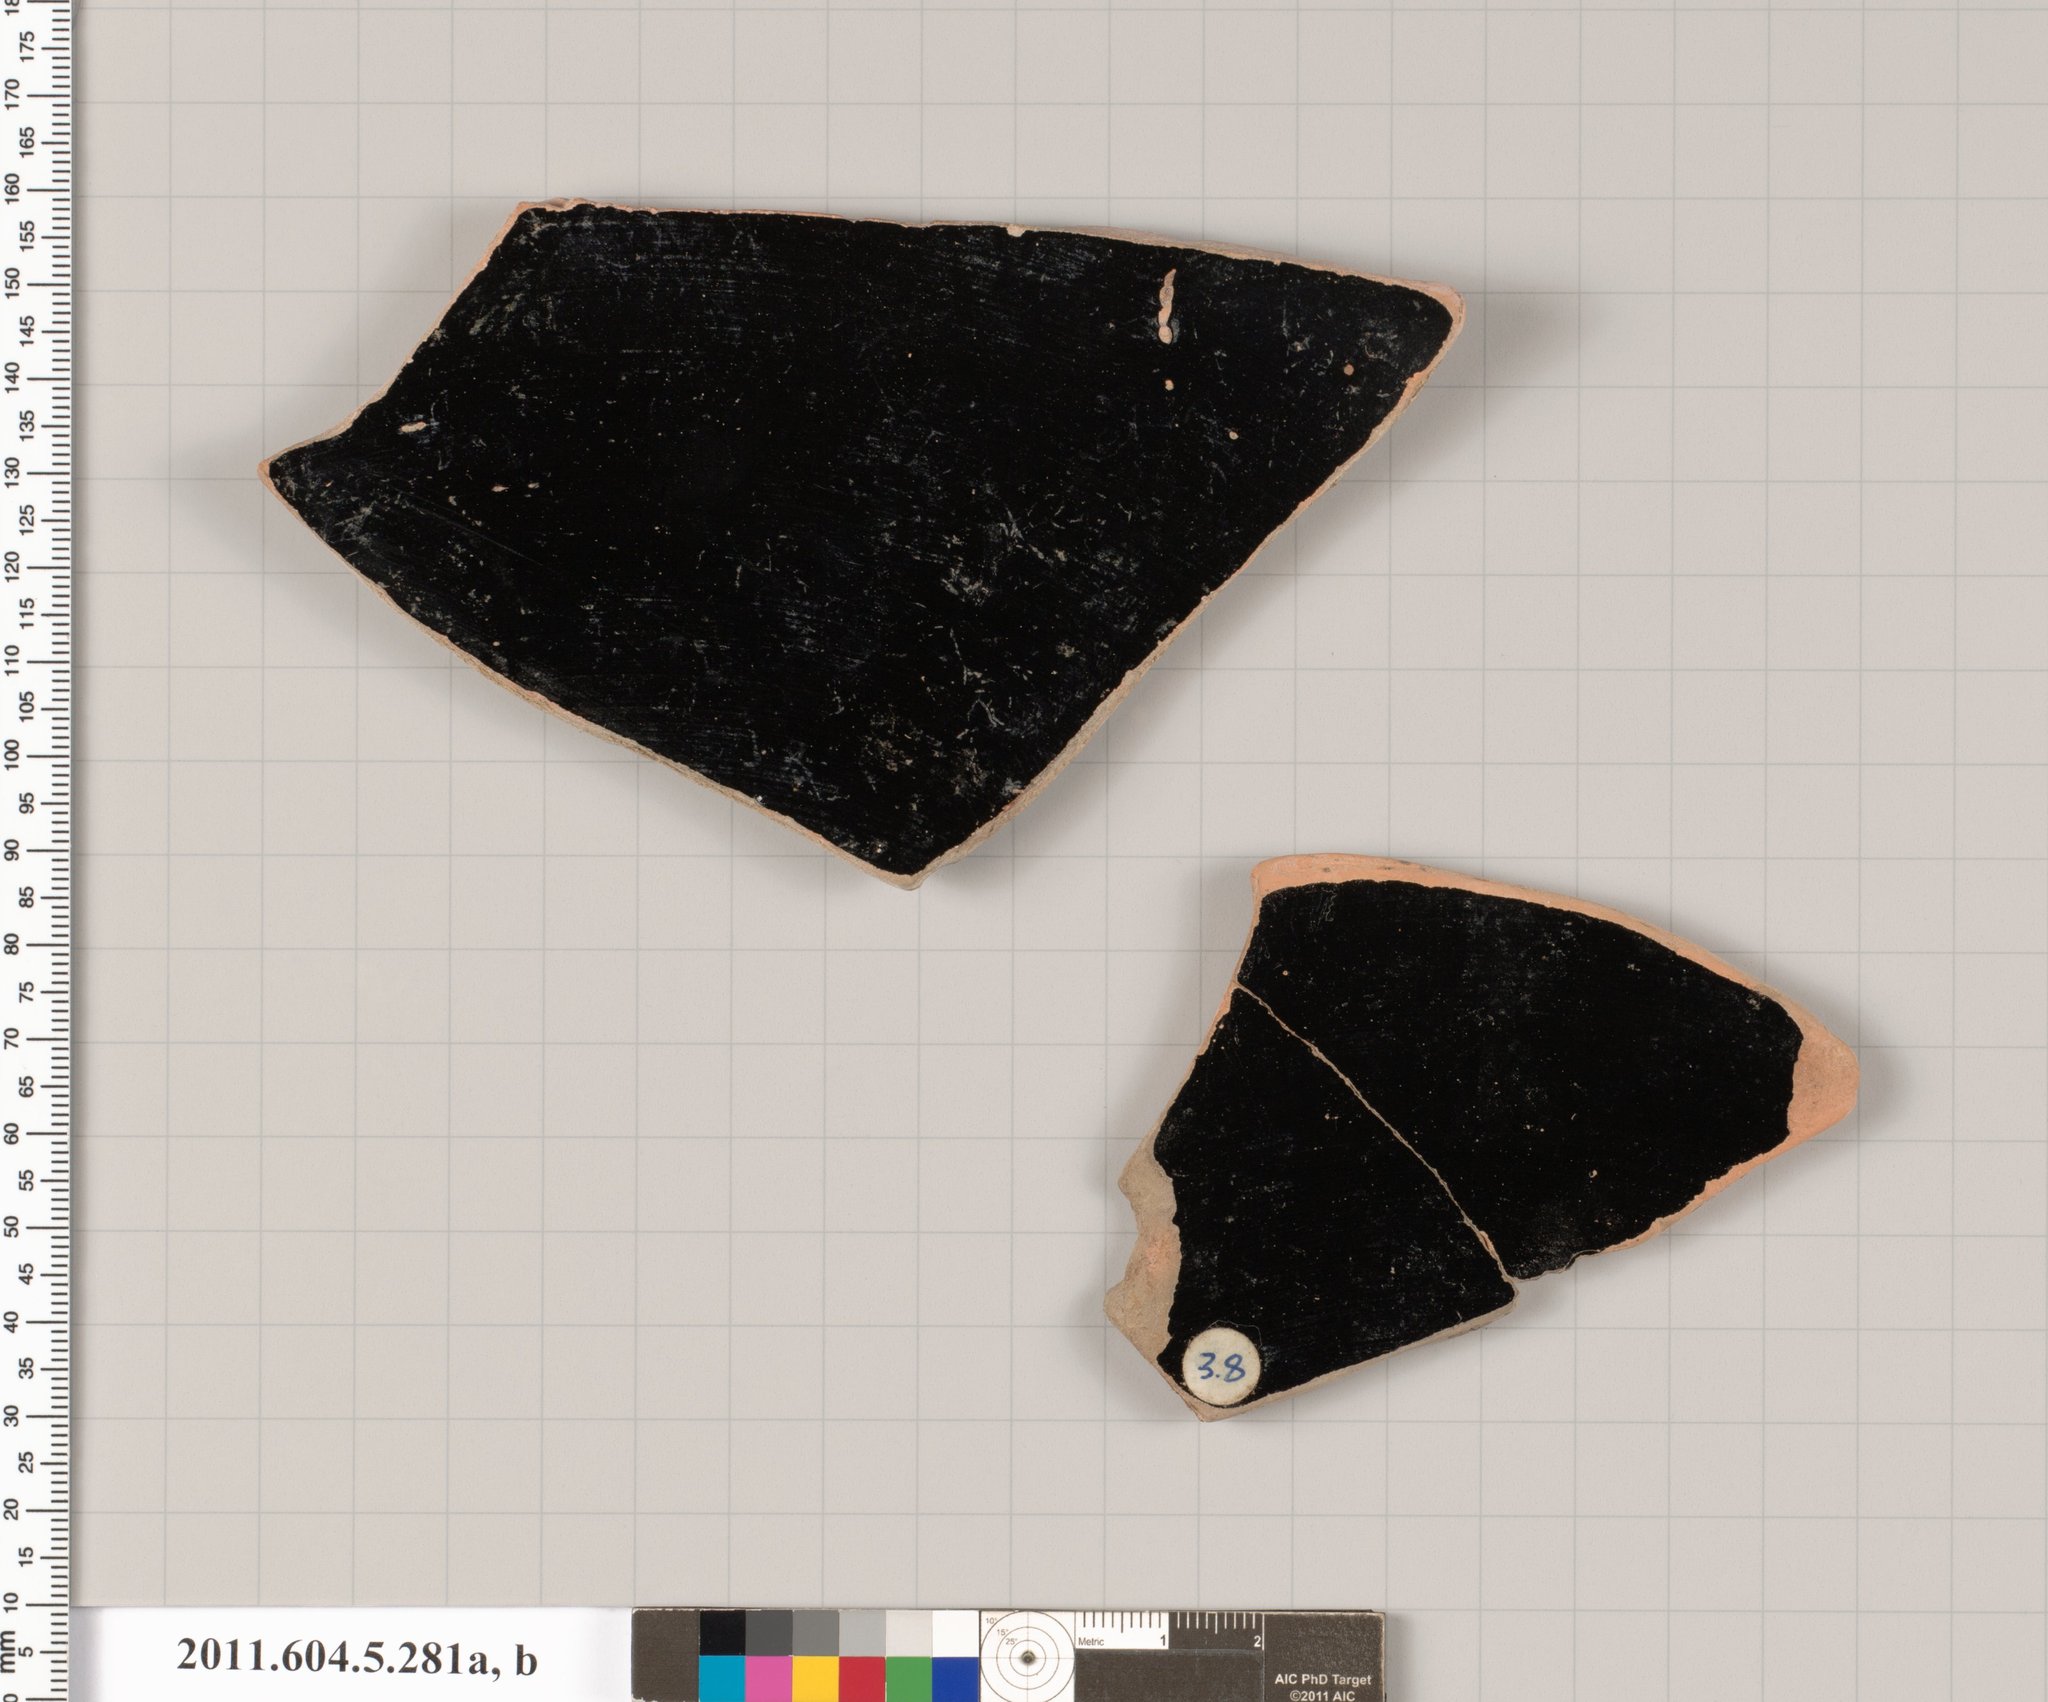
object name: kylix fragment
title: Terracotta fragments of a kylix (drinking cup)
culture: greek, attic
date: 600-401 BCE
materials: terracotta